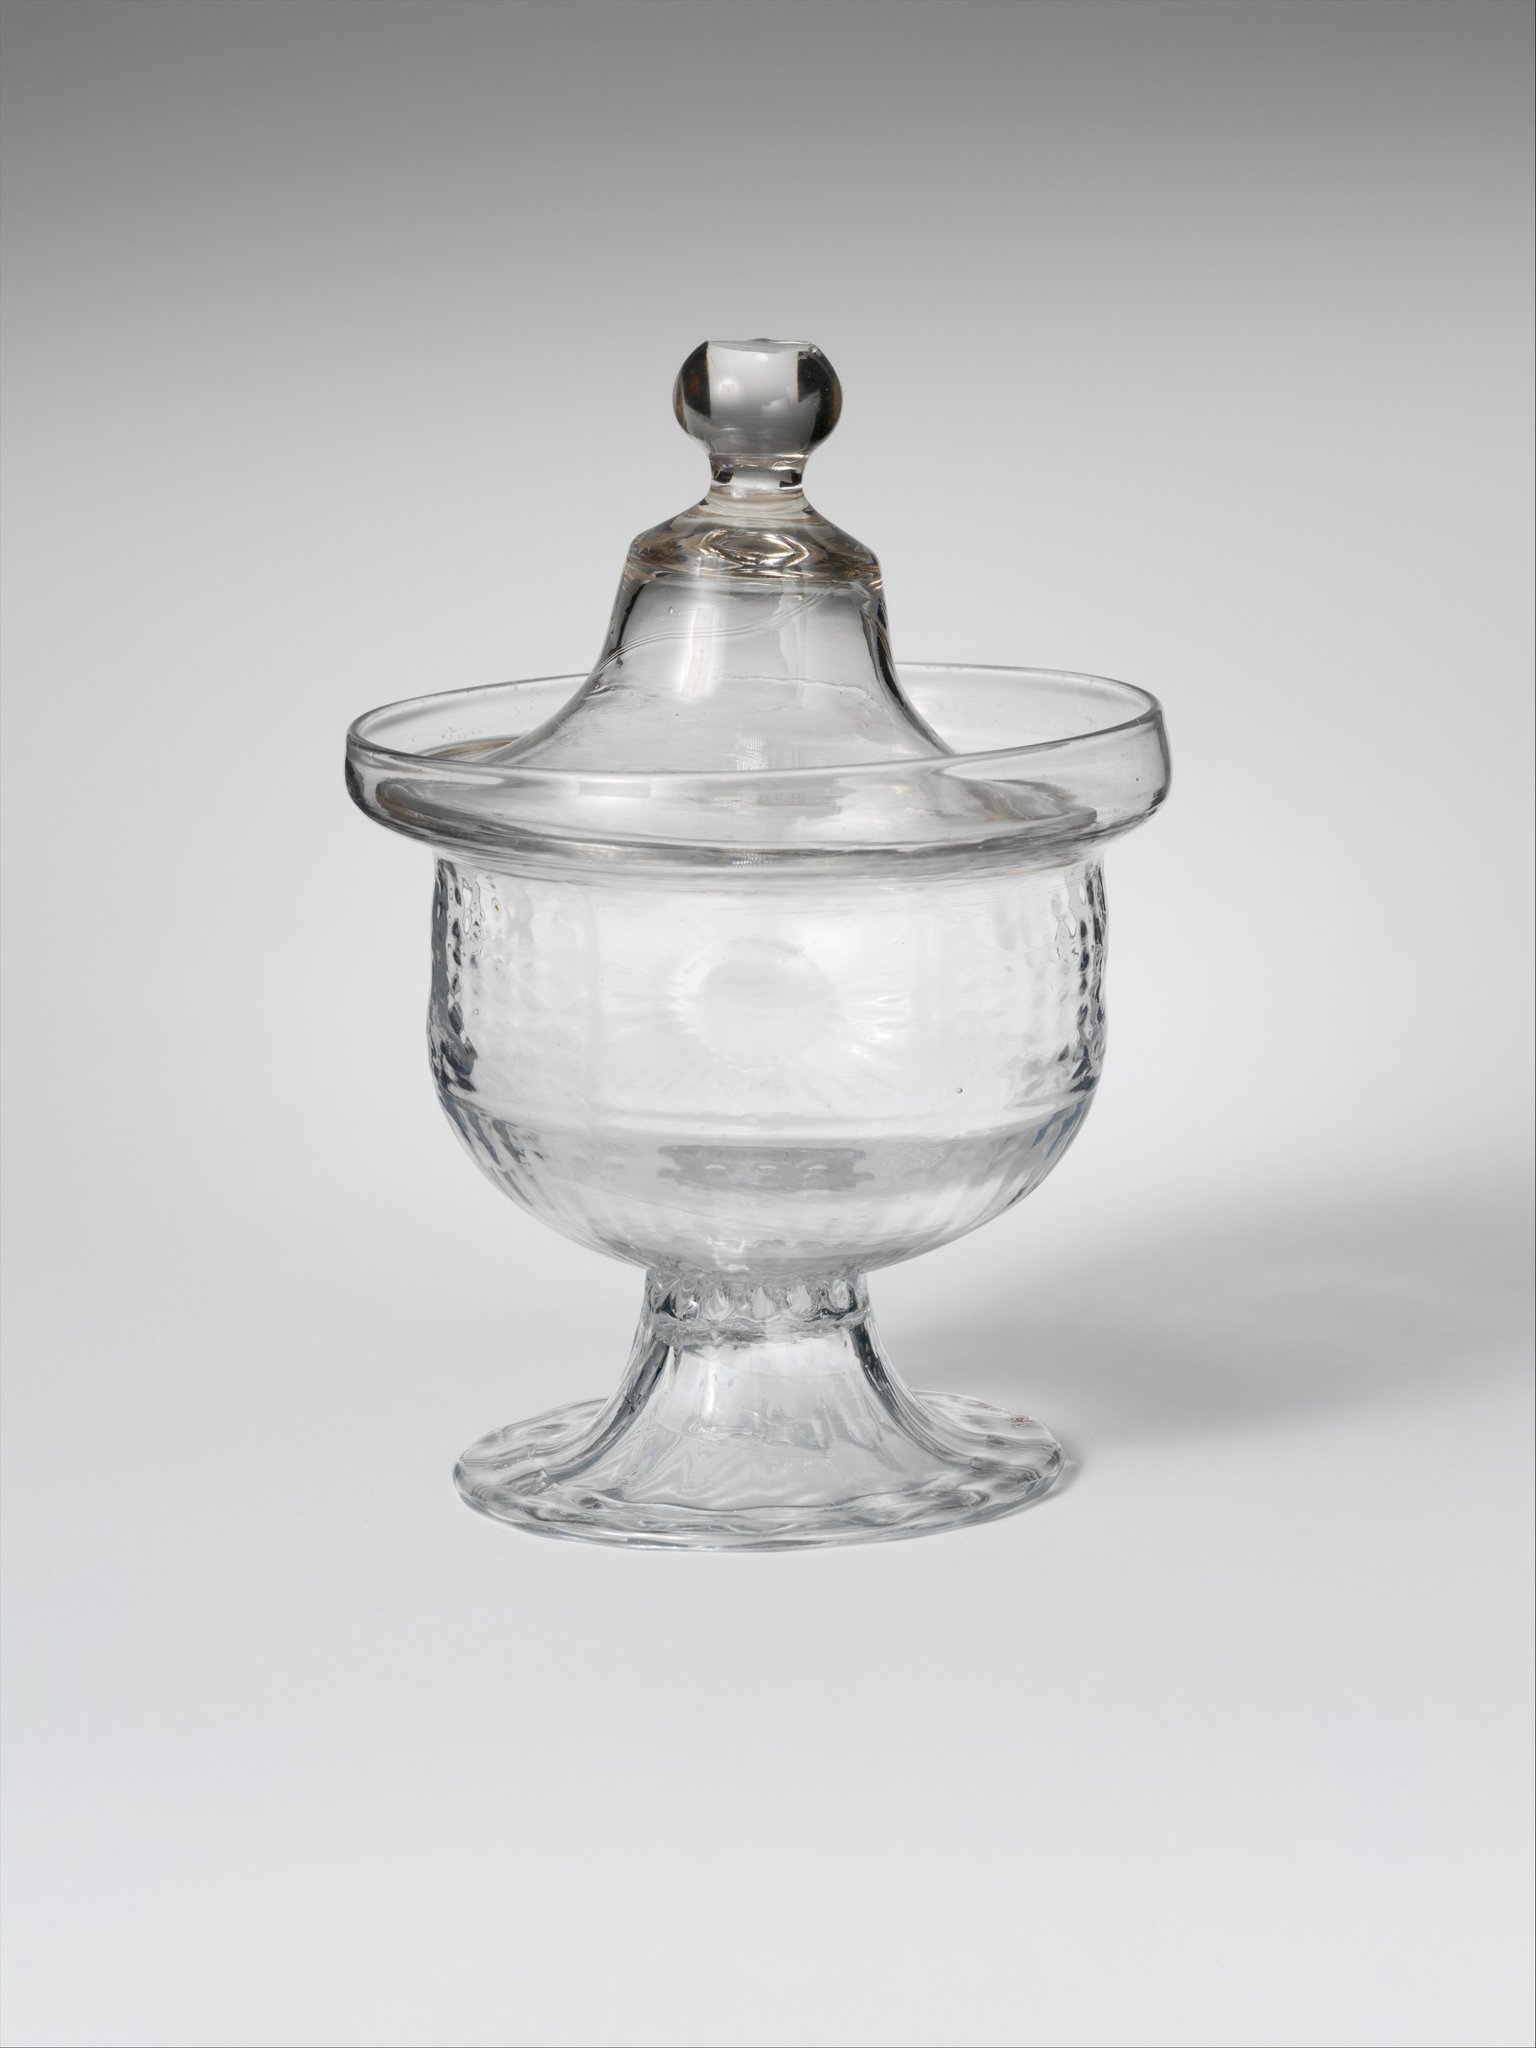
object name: sugar bowl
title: Covered Sugar Bowl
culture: american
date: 1820-1840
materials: glass, lead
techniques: glassblowing, molding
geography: united states